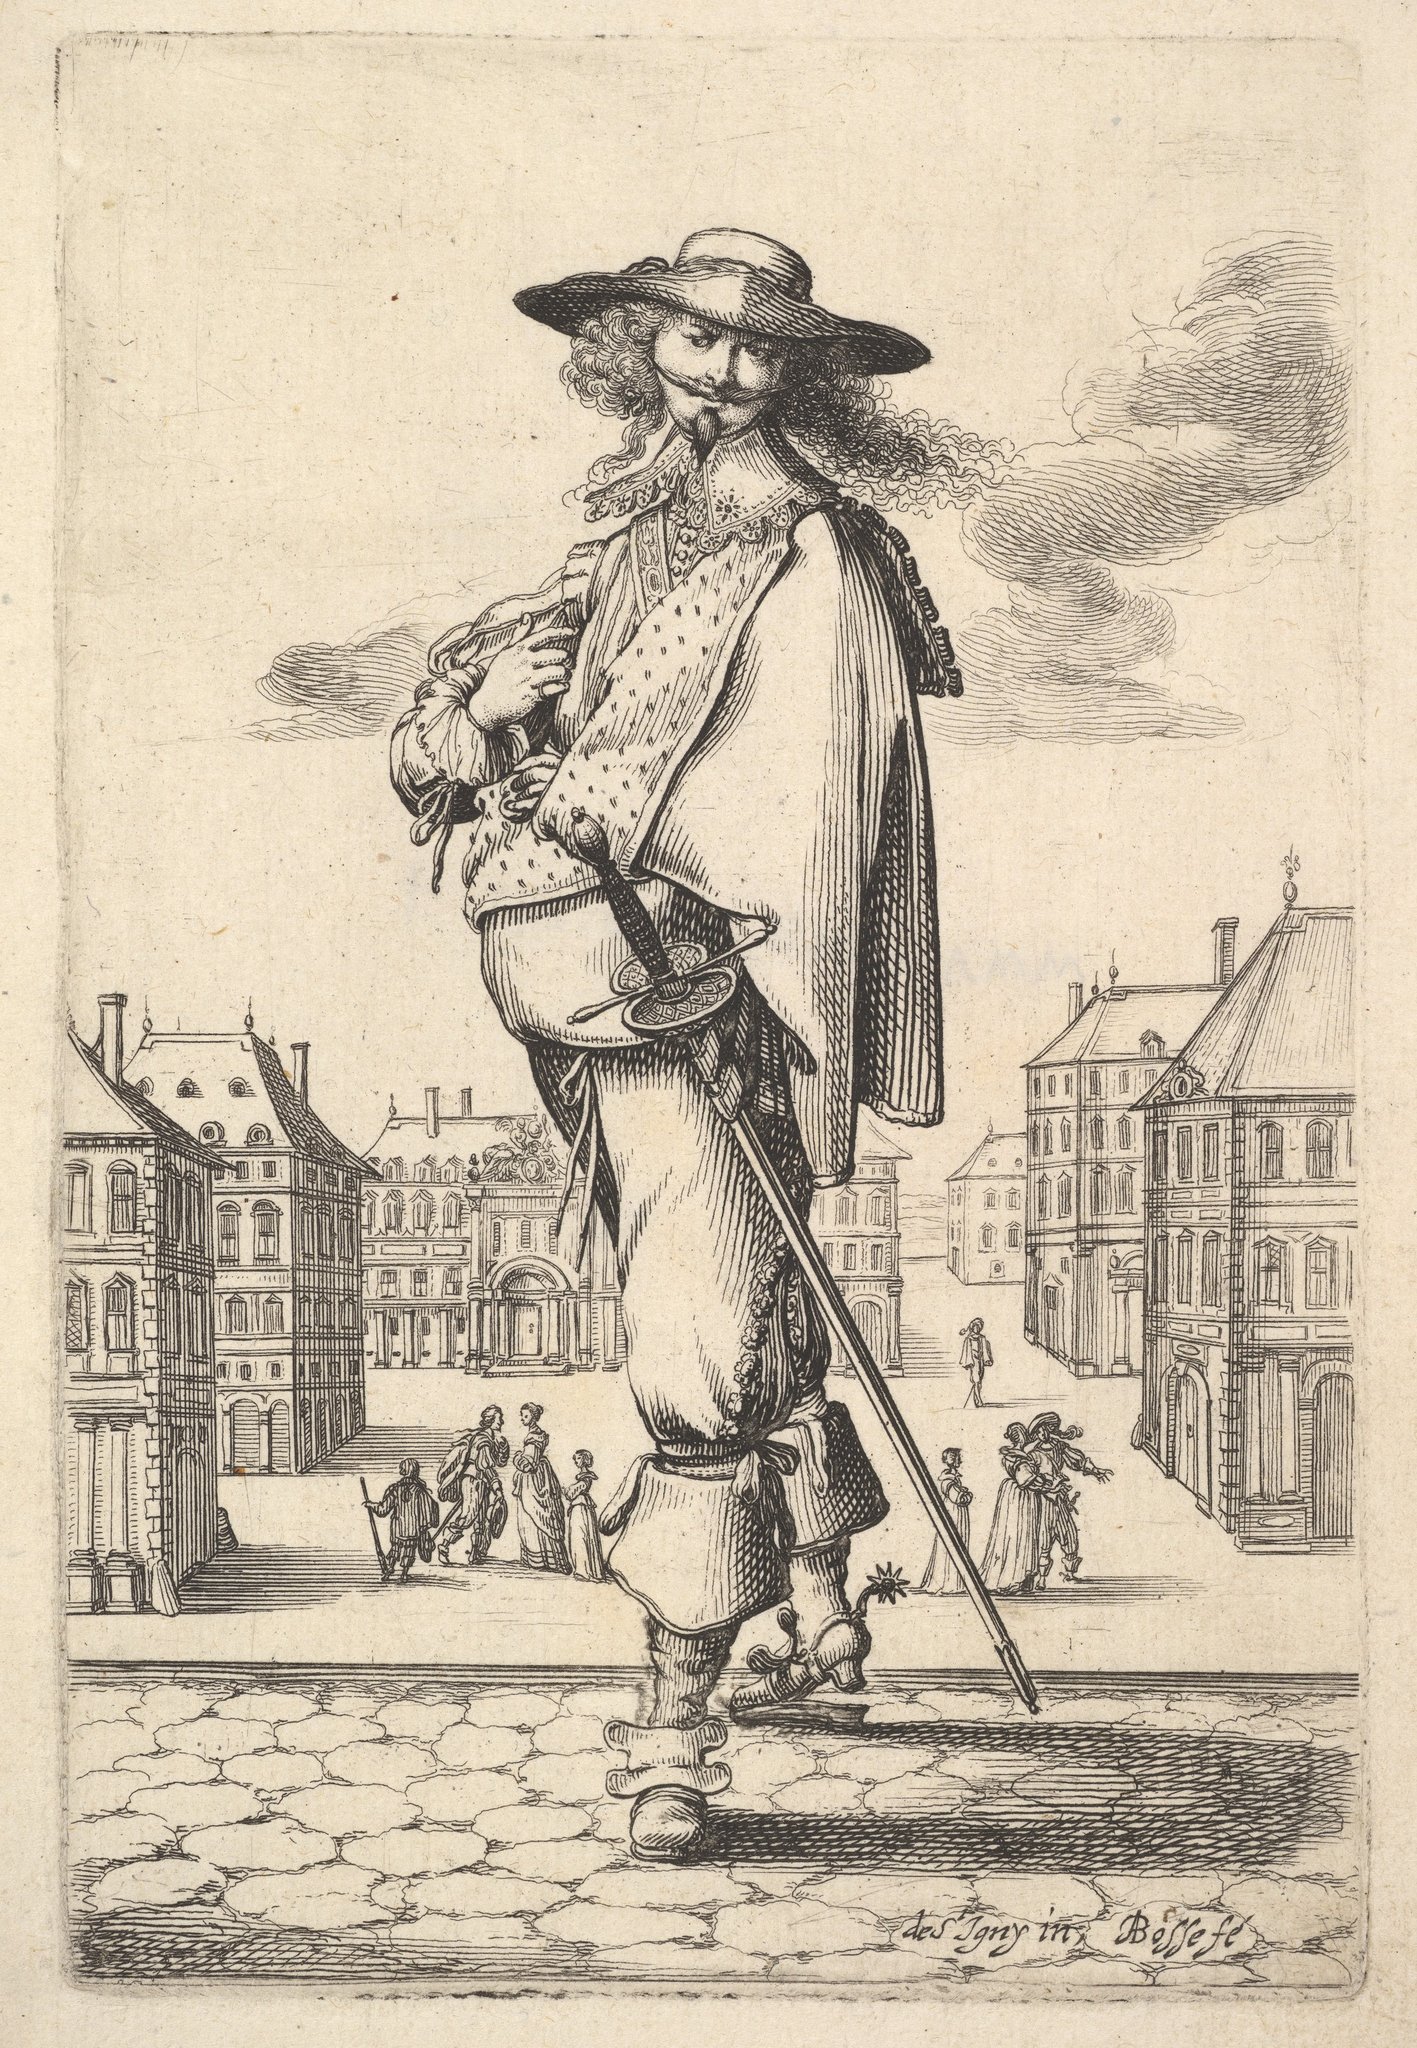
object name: print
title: A gentleman, turned three-quarters to the left, wearing a hat and boots with spurs, carrying a sword in his belt, a town square in the background, from "The Garden of the French Nobles In Which One Can Pick Up Their Way of Dressing"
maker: abraham bosse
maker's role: artist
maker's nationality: french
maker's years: 1602-1676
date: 1629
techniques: etching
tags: buildings,men